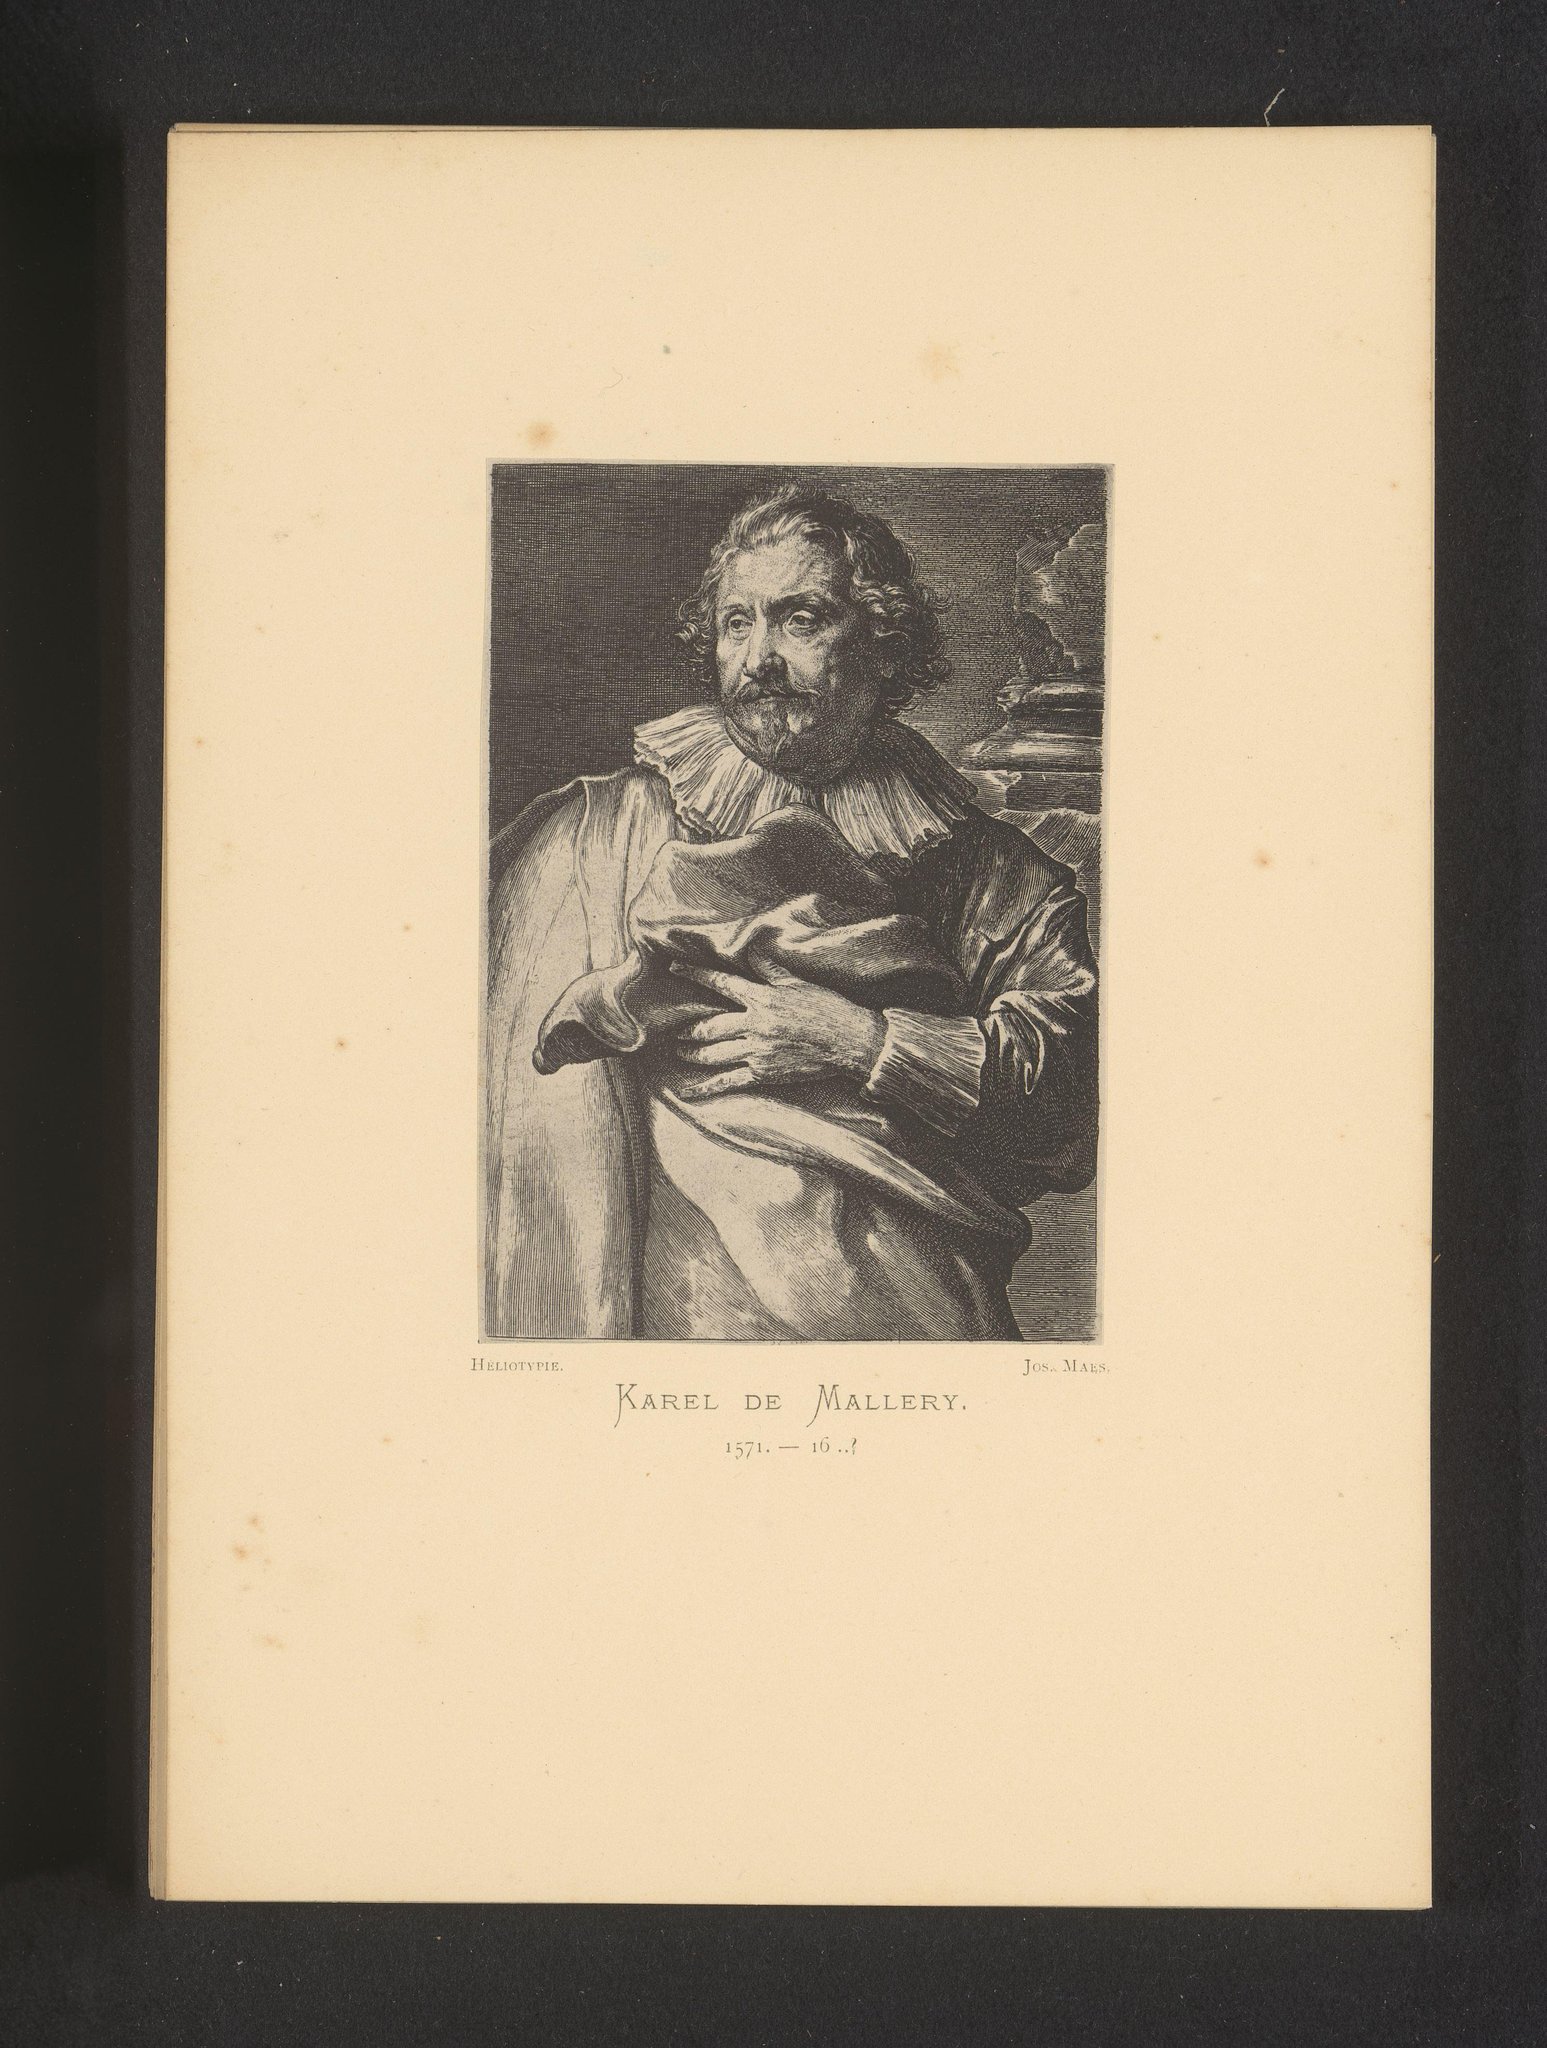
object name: reproduction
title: Reproductie van een gravure van een portret van Karel van Mallery door Lucas Vorsterman (I)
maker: joseph maes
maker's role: fotograaf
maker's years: 1838-1908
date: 1872-1877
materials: cardboard, paper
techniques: photograph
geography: antwerp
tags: karel van mallery, historical persons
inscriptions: inscription: ‘1571. - 16..?’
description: Deze prent maakt deel uit van een omslag met 150 prenten en een katern met een lijst van afbeeldingen.